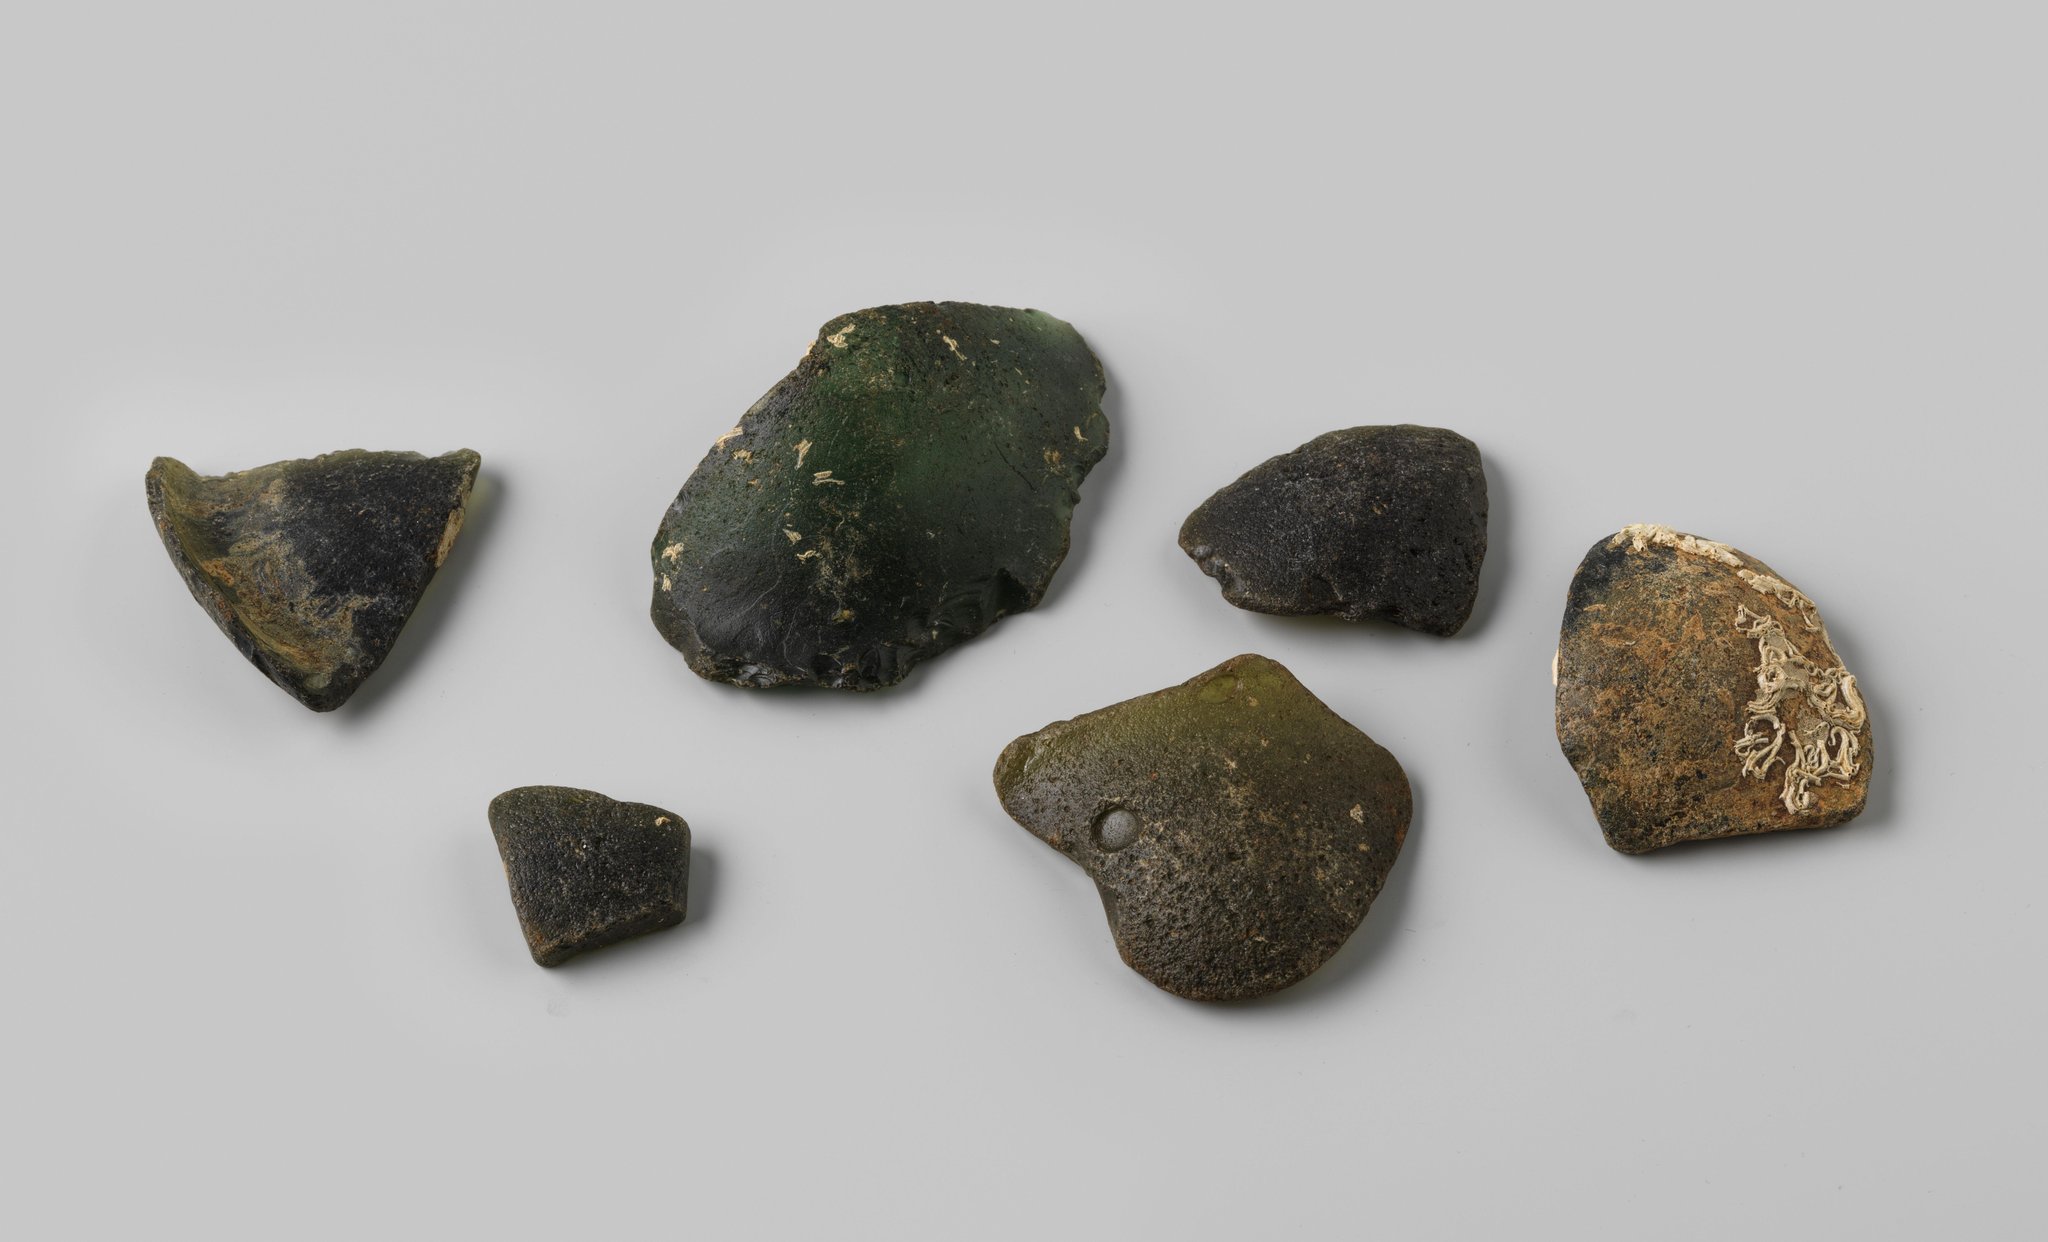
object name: sherd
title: Scherven van wijnflessen uit het wrak van de Oost-Indiëvaarder Hollandia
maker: Anonymous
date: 1700-1743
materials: glass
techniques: green glass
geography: netherlands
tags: verenigde oostindische compagnie, hollandia (schip), annet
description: Onion-shaped bottle or bottle with vertical side, base, fragm, tcs-kick-up, fragm, cs-kick-up. Continental production.